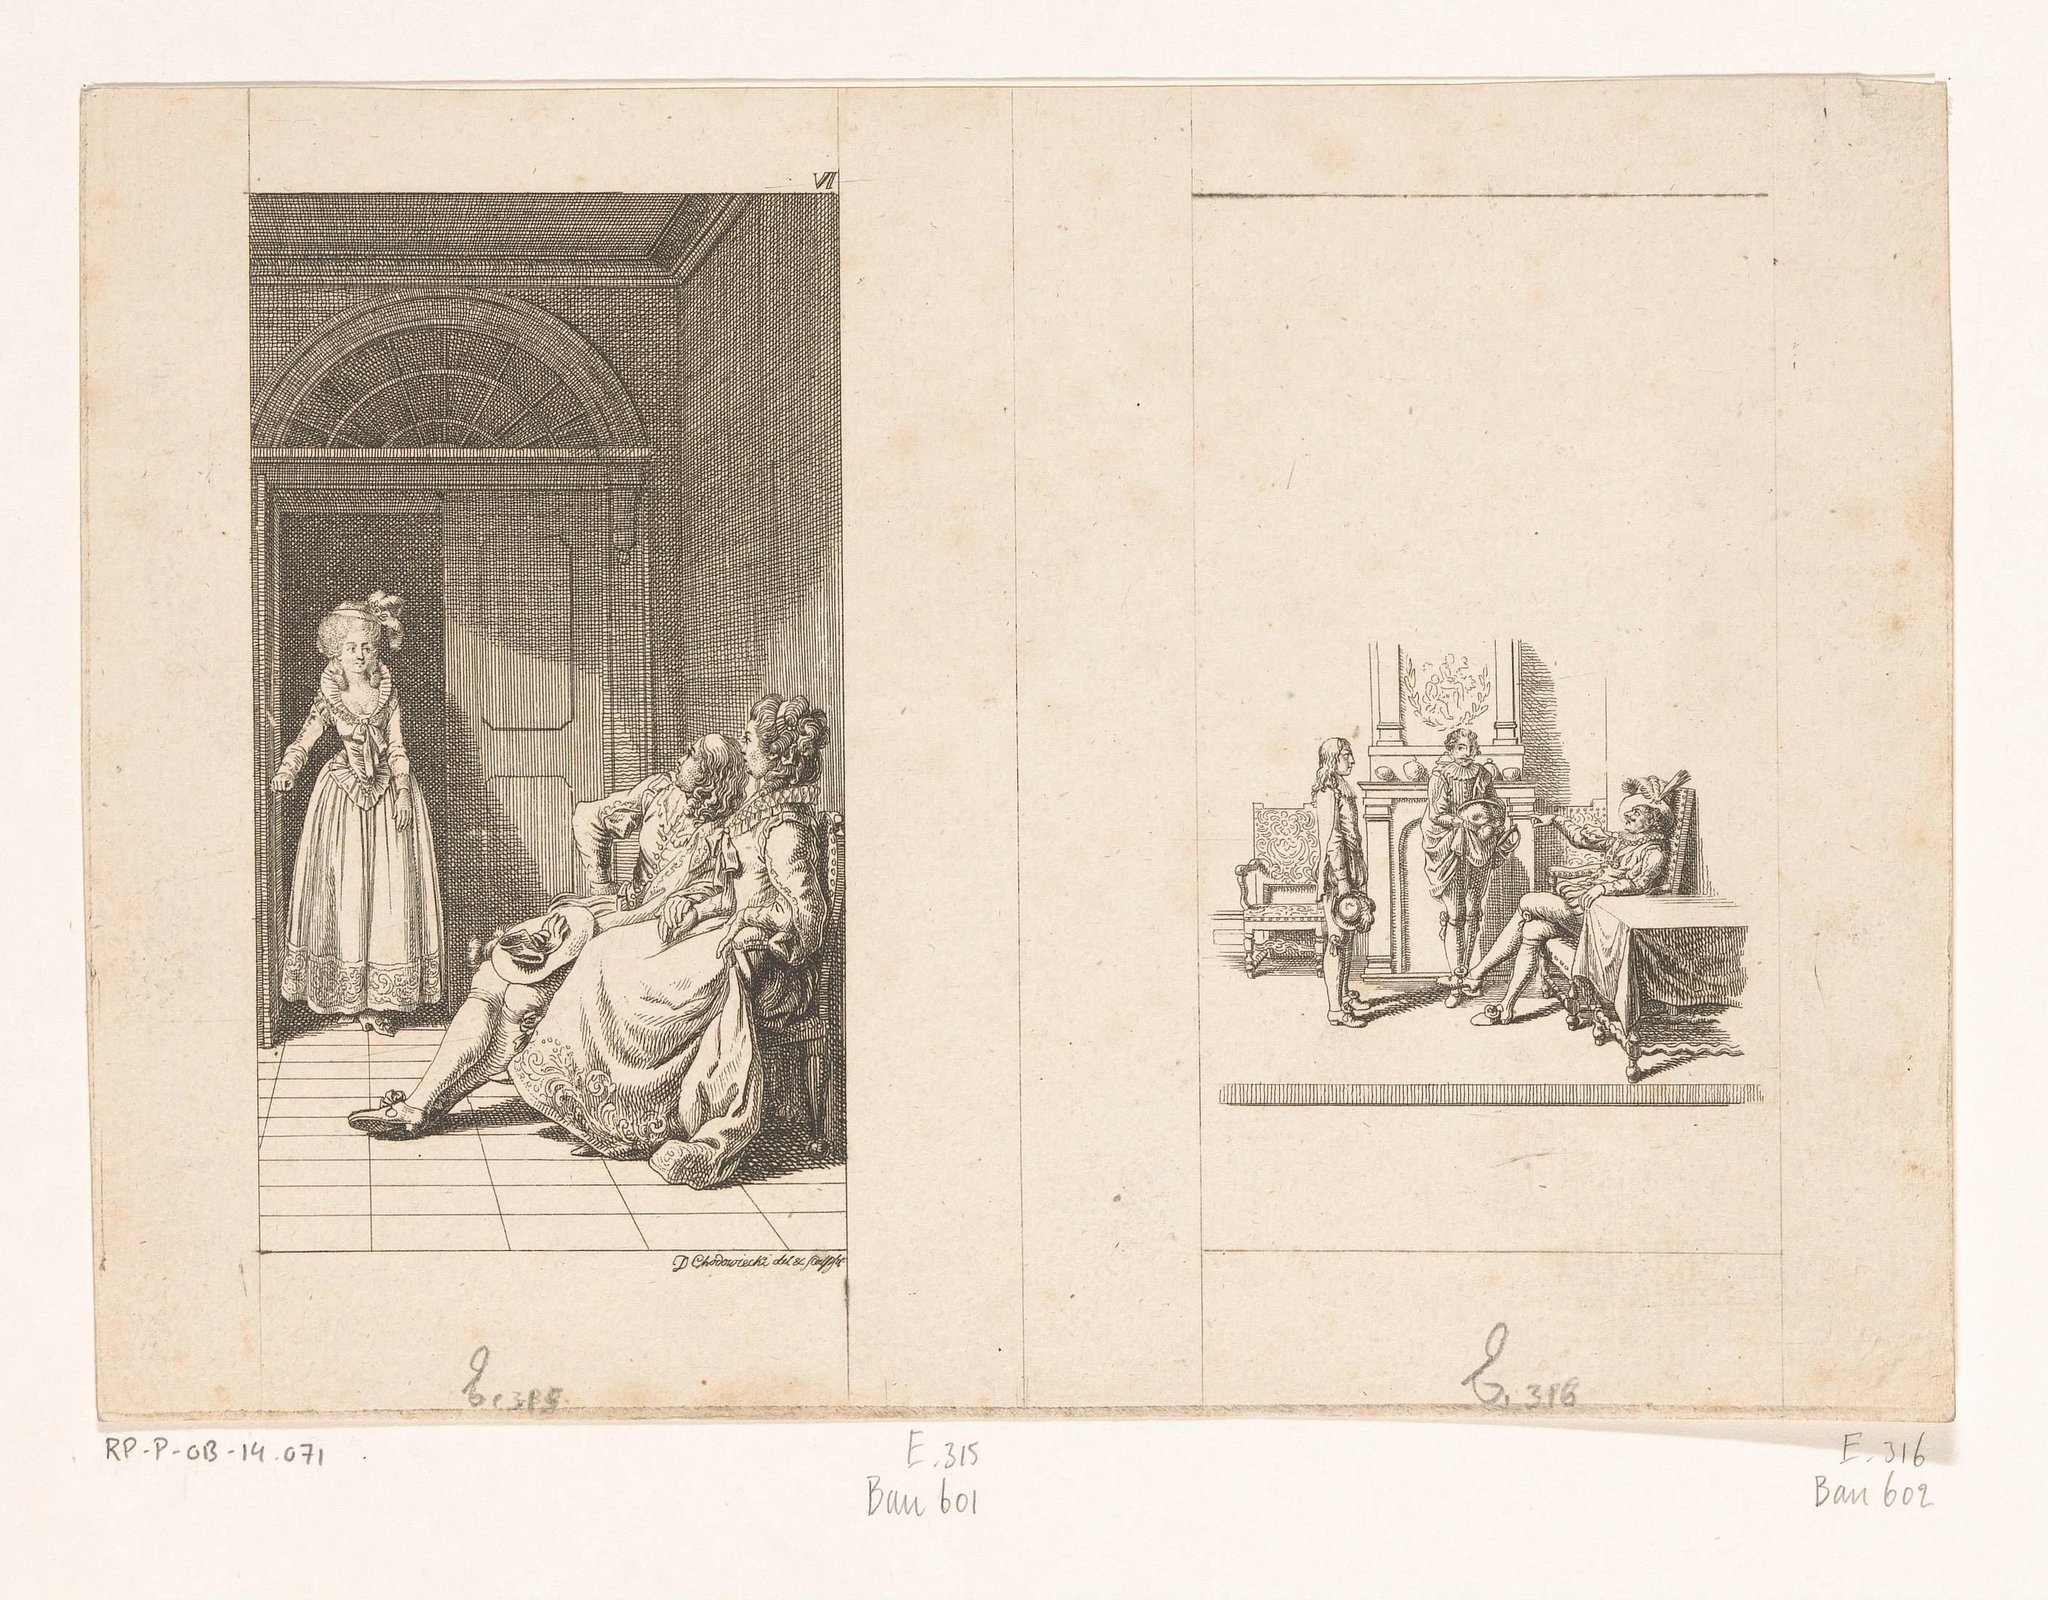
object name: print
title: Gil Blas en Lukrezia en vignet met Gil Blas voor erfprins Filips van Spanje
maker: daniel nikolaus chodowiecki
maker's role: draughtsman, print maker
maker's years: 1726-1801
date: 1779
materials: paper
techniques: etching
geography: berlin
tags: filips iv (koning van spanje), literature, audition; ruler giving audience, conversation, dialogue; conversation piece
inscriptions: collector's mark: Lugt 2228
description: Links bespreekt Gil Blas met Estrella, zijn oude liefde Laura, de toekomst van 'nicht' Lukrezia. Op het moment dat Estrella zich verspreekt en het Gil Blas duidelijk wordt dat Lukrezia eigenlijk zijn dochter is, komt de veertienjarige binnen. Rechts Gil Blas op audiëntie bij erfprins Filips van Spanje (rechts op een leunstoel). De prins beveelt hem aan bij de graaf van Leyra (staand voor de schouw).